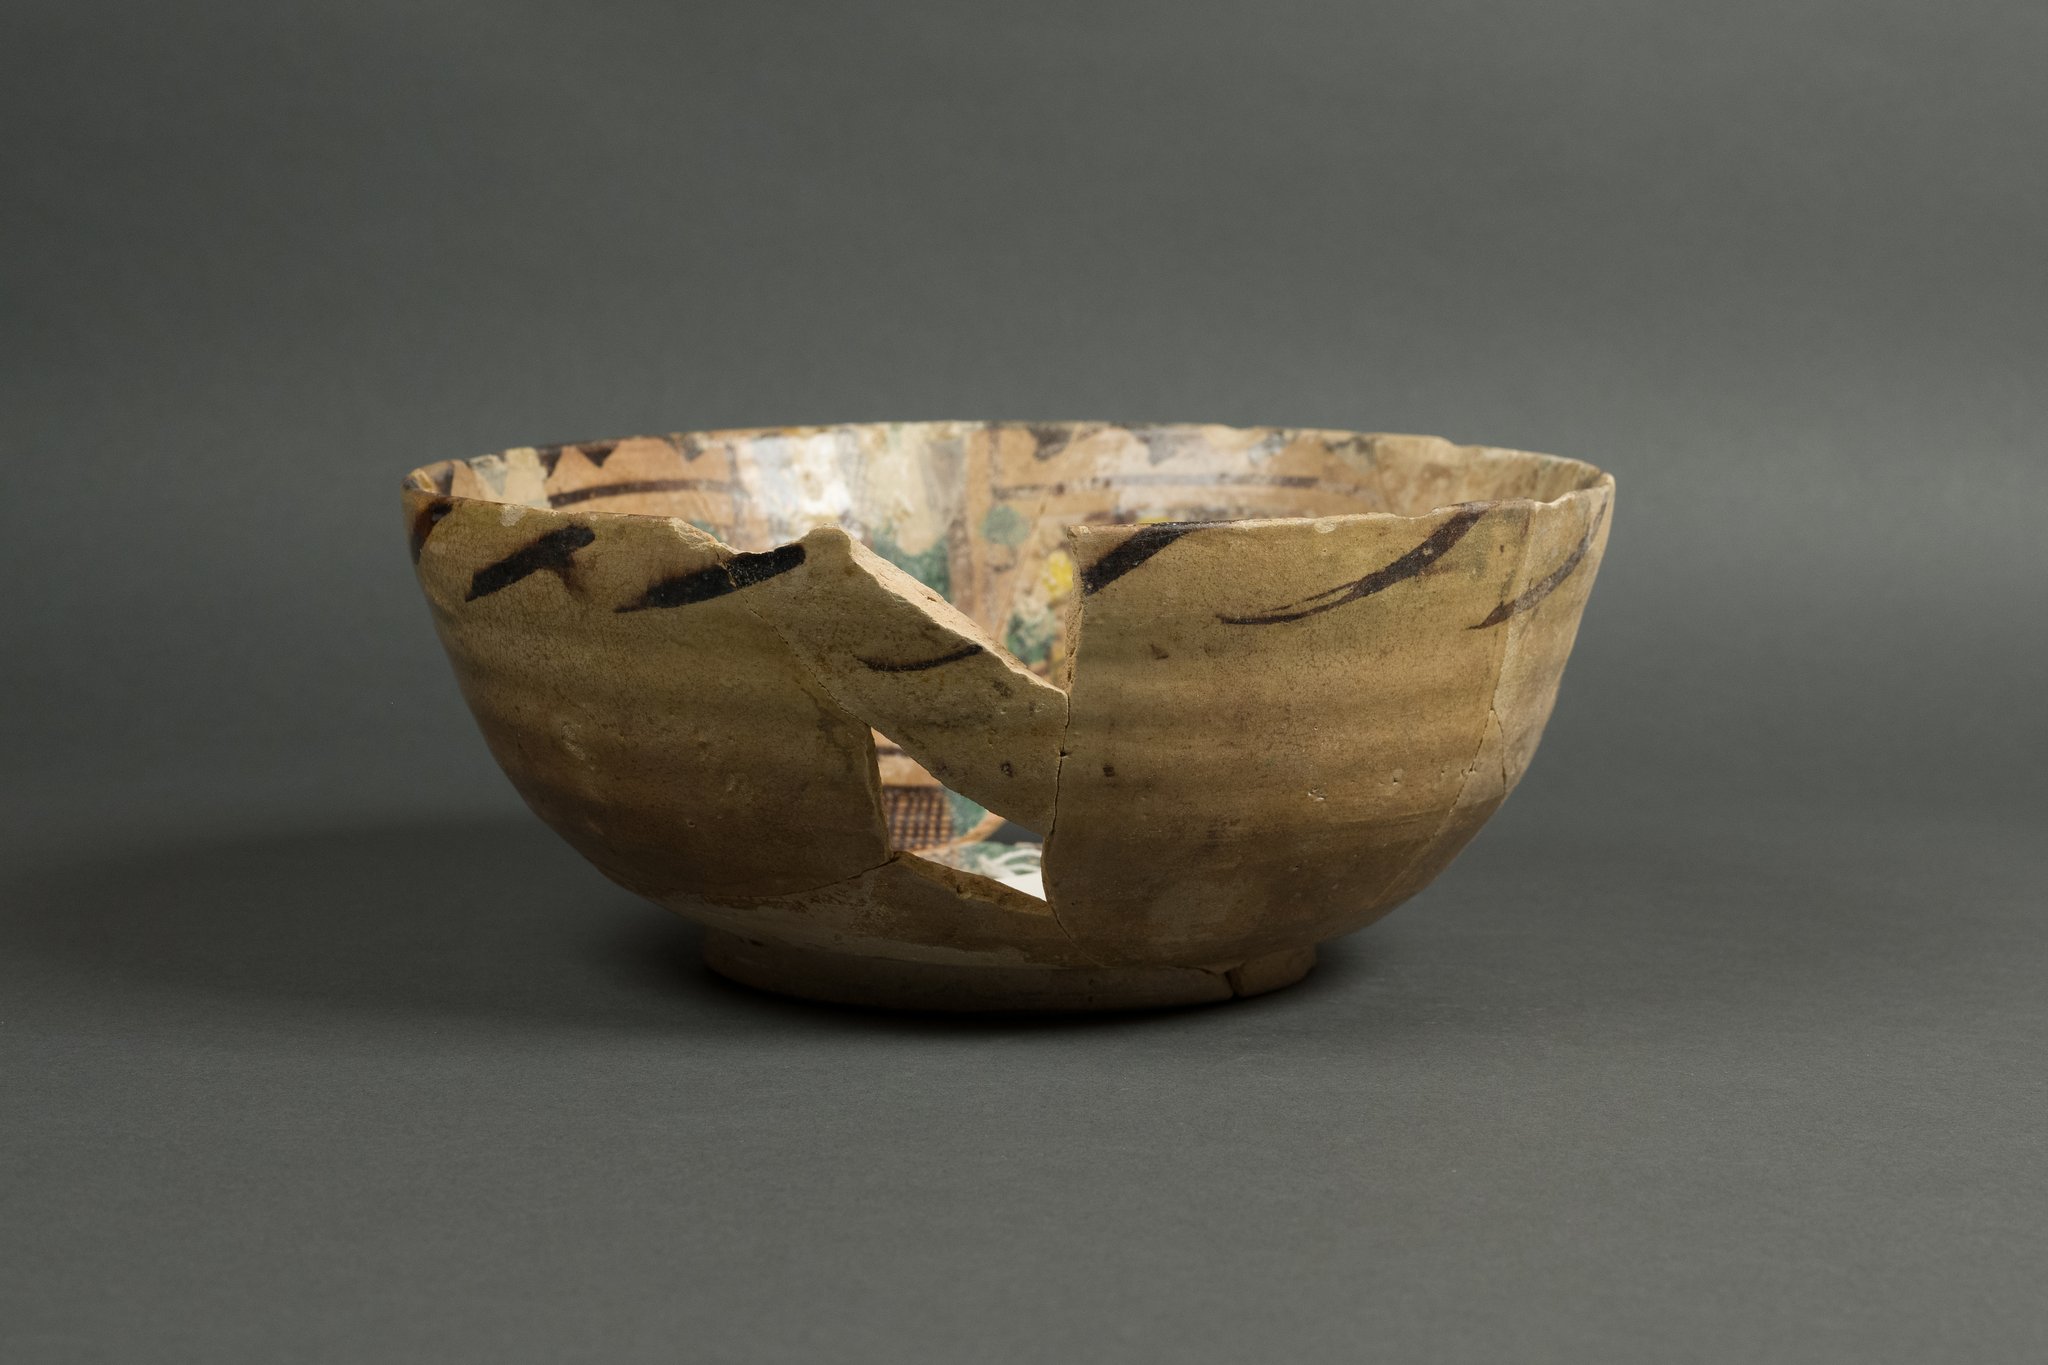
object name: bowl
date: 801-900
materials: earthenware, glaze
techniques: incising, polychrome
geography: iran